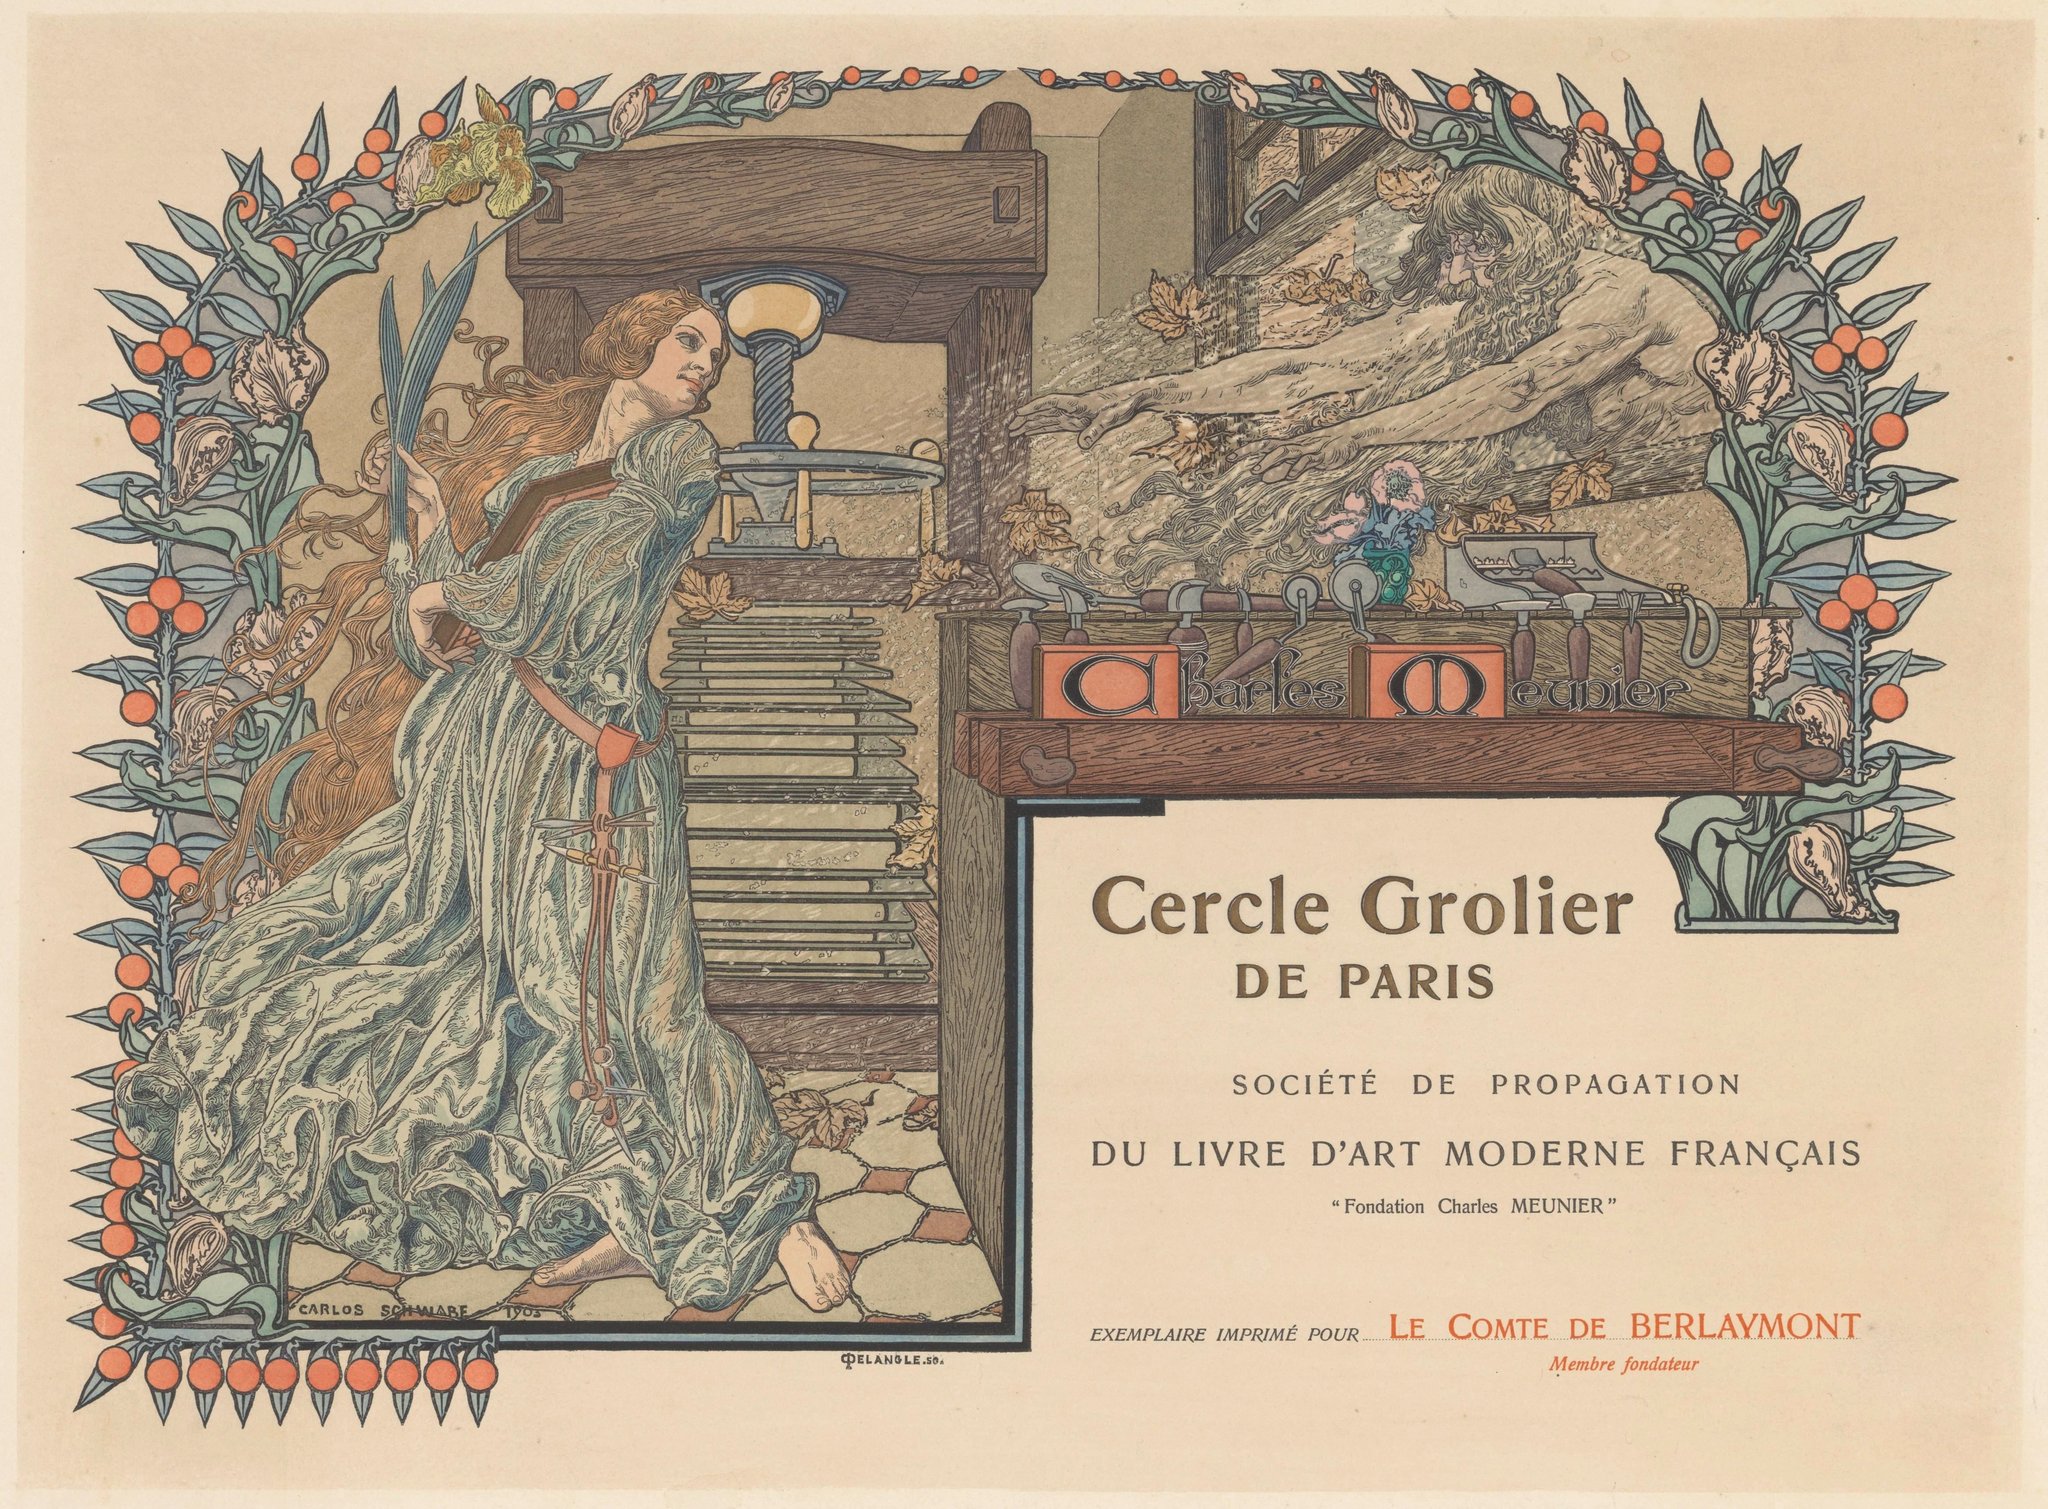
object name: print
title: Affiche voor de Cercle Grolier de Paris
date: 1903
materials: paper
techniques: hand coloring, letterpress printing, engraving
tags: bookbinding, wind as a human face, blowing with rounded cheeks, tools, implements of graphic artist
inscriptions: collector's mark: Lugt 3751, collector's mark: Lugt 2228, watermark: ‘J. Perrigot Arches’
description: Voor een boekenpers staat een vrouw met een boek in haar armen en de steel van een iris in haar hand. Aan haar riem bungelen de gereedschappen van een prentmaker. Haar blik is gericht op de personificatie van de wind die door het openstaande raam naar binnen probeert te komen. Aan de werkbank op de voorgrond hangen gereedschappen van een boekbinder.